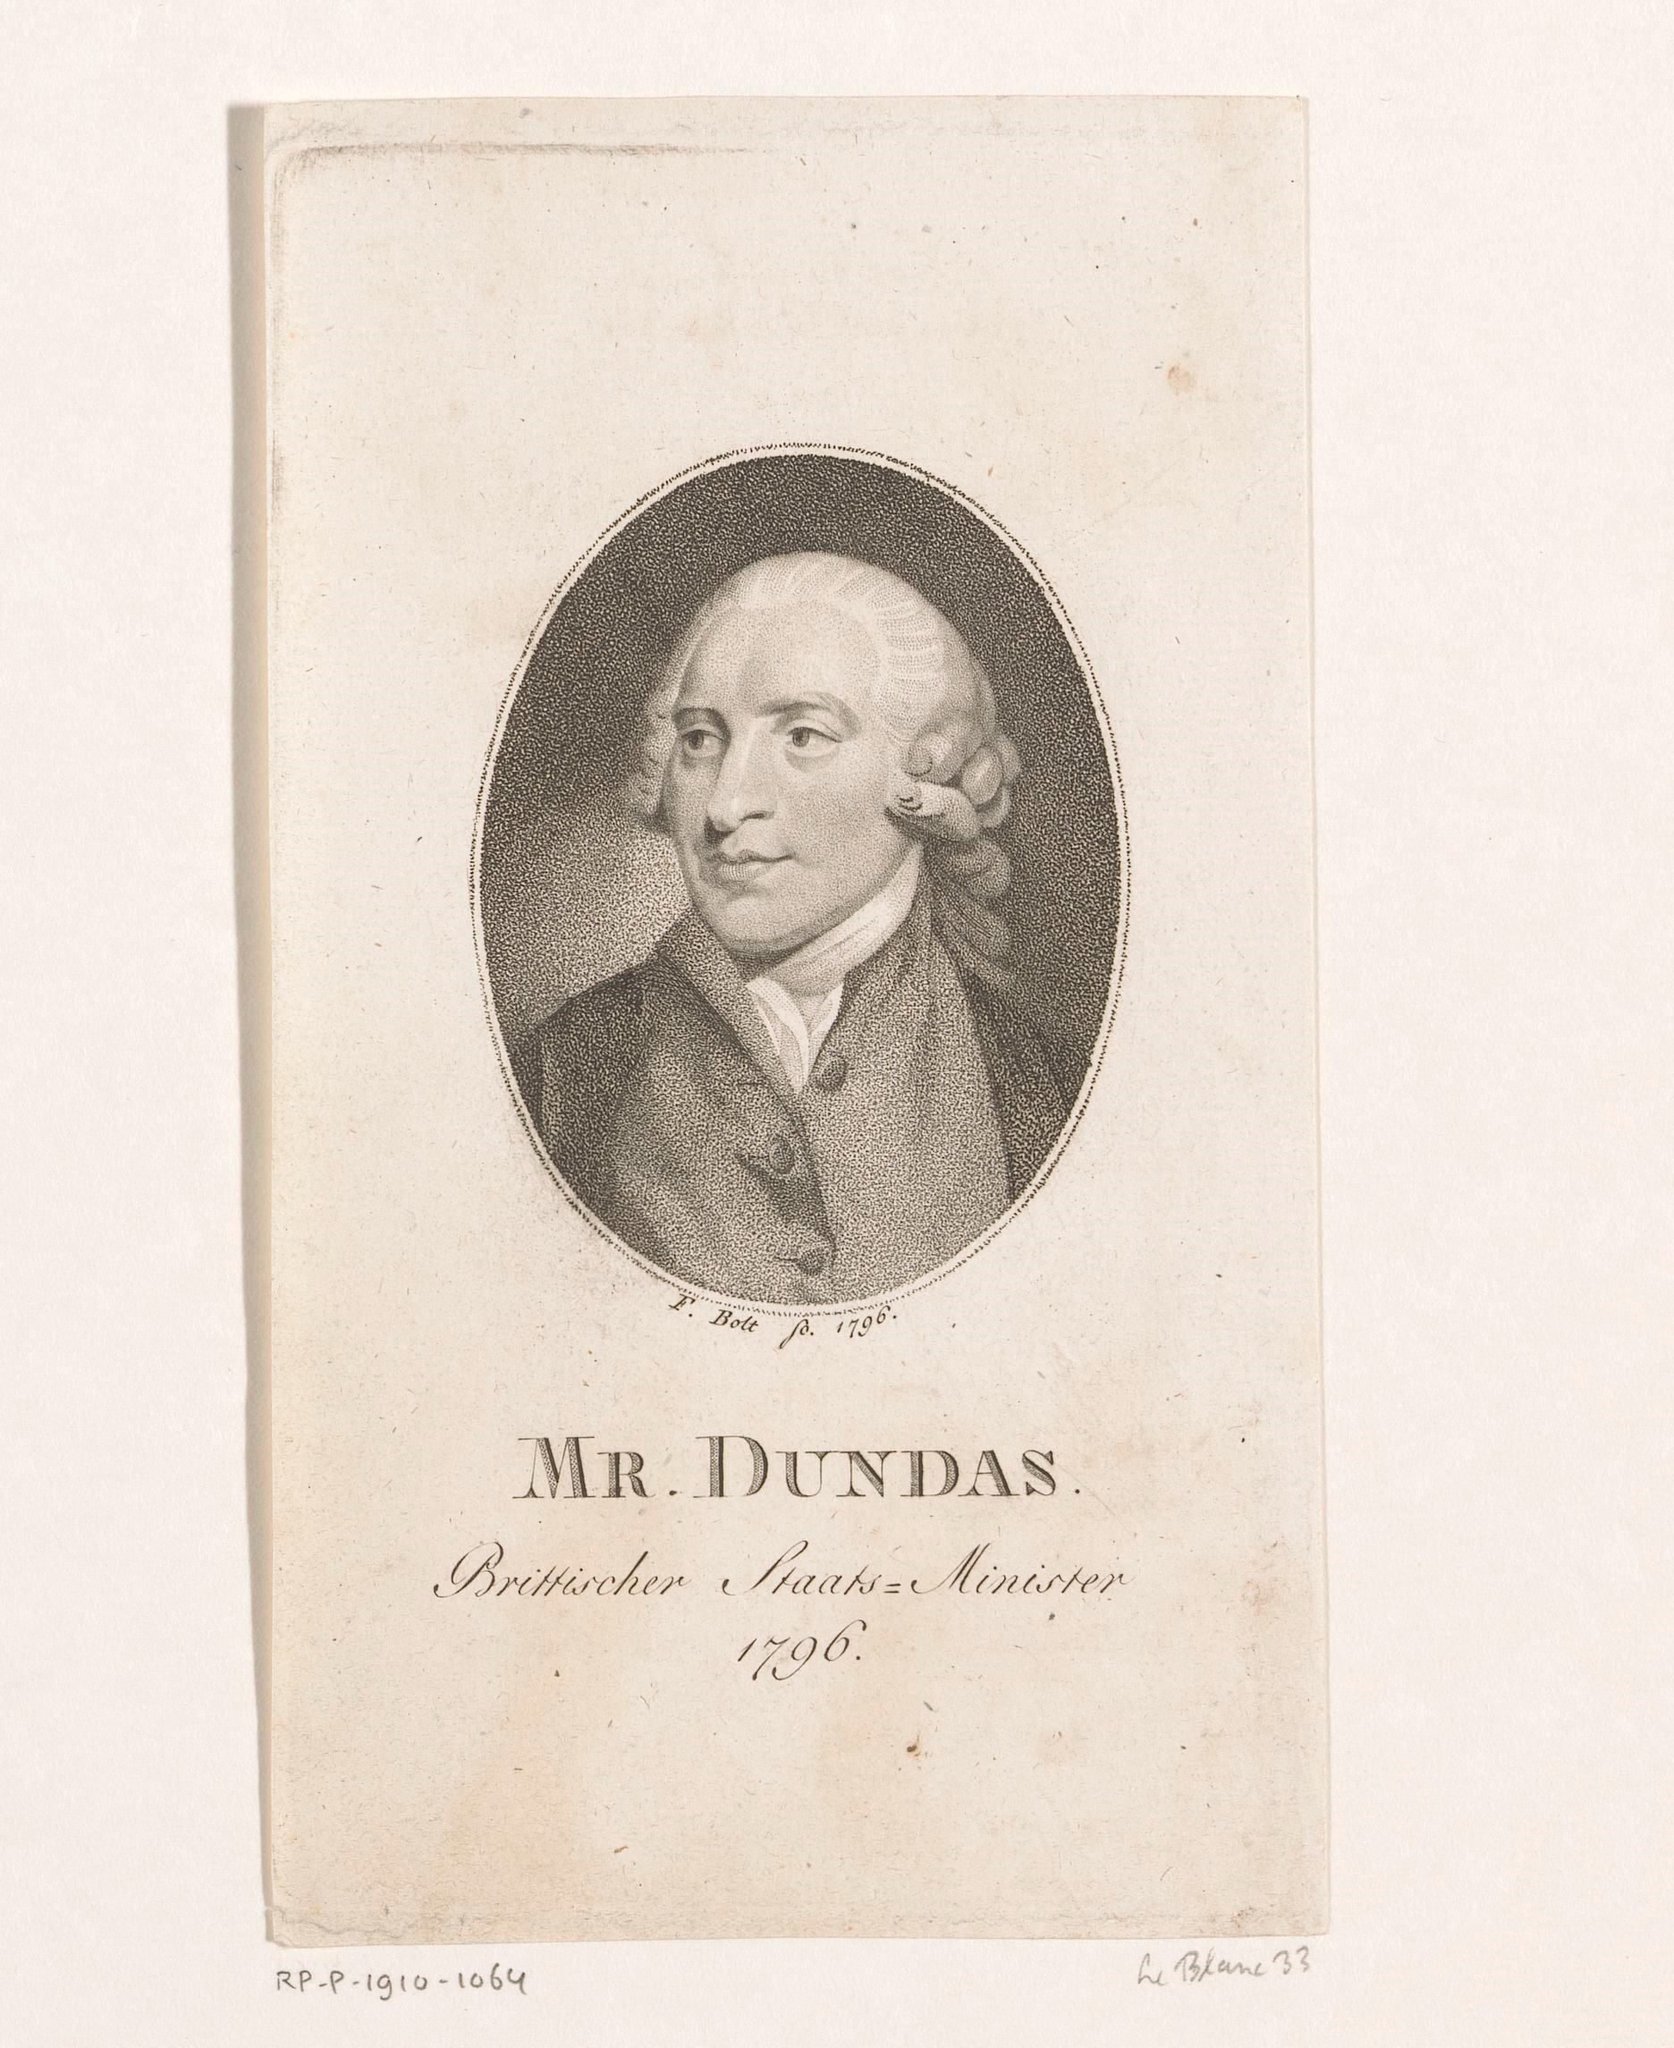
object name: print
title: Portret van Henry Dundas, 1st Viscount Melville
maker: johann friedrich bolt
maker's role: print maker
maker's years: 1769-1836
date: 1796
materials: paper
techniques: stippling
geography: berlin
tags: historical persons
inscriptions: collector's mark: Lugt 2228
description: Prent ook gebruikt in: Archenholz, Johann Wilhelm von. Annalen der Brittischen Geschichte. 19 dln. Tübingen, Cotta, 1788-1793, dl. 13 [1796].